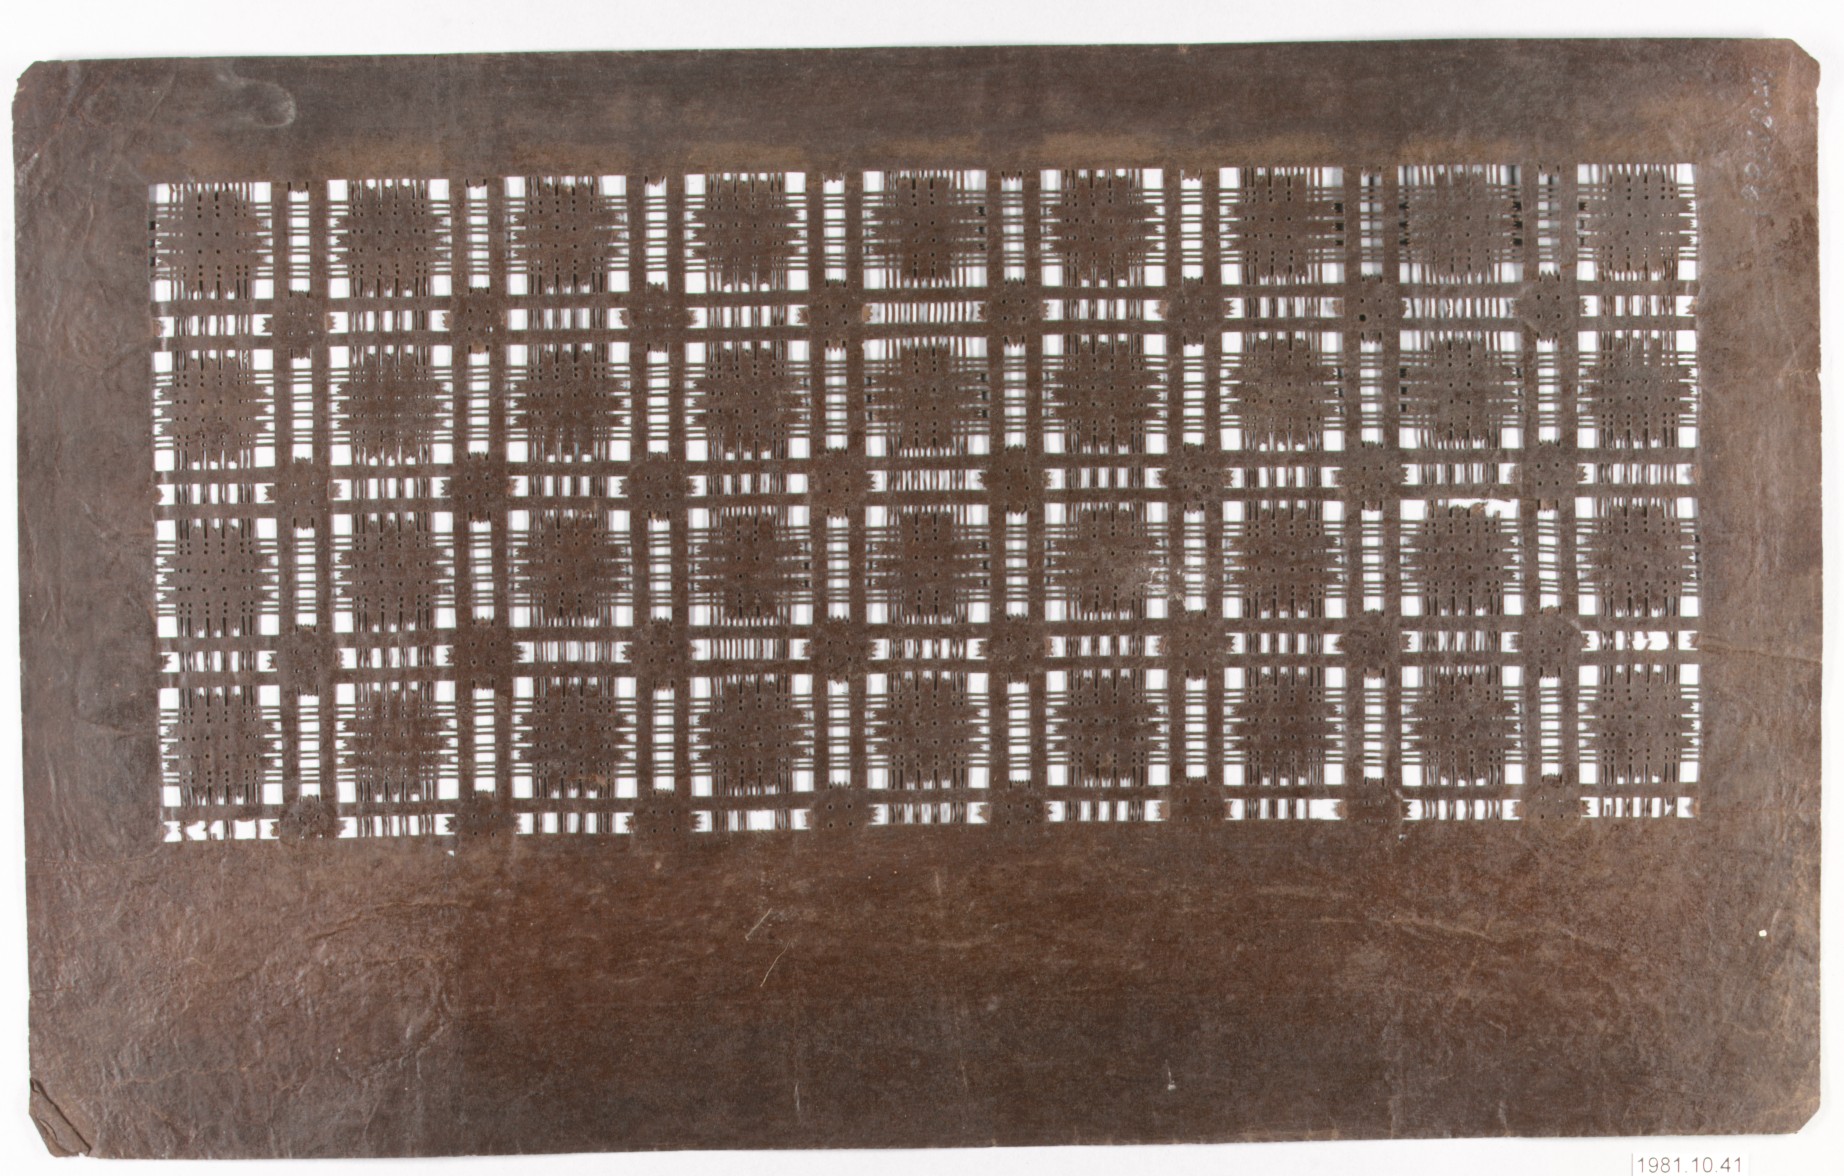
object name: stencil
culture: japanese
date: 1801-1900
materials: paper